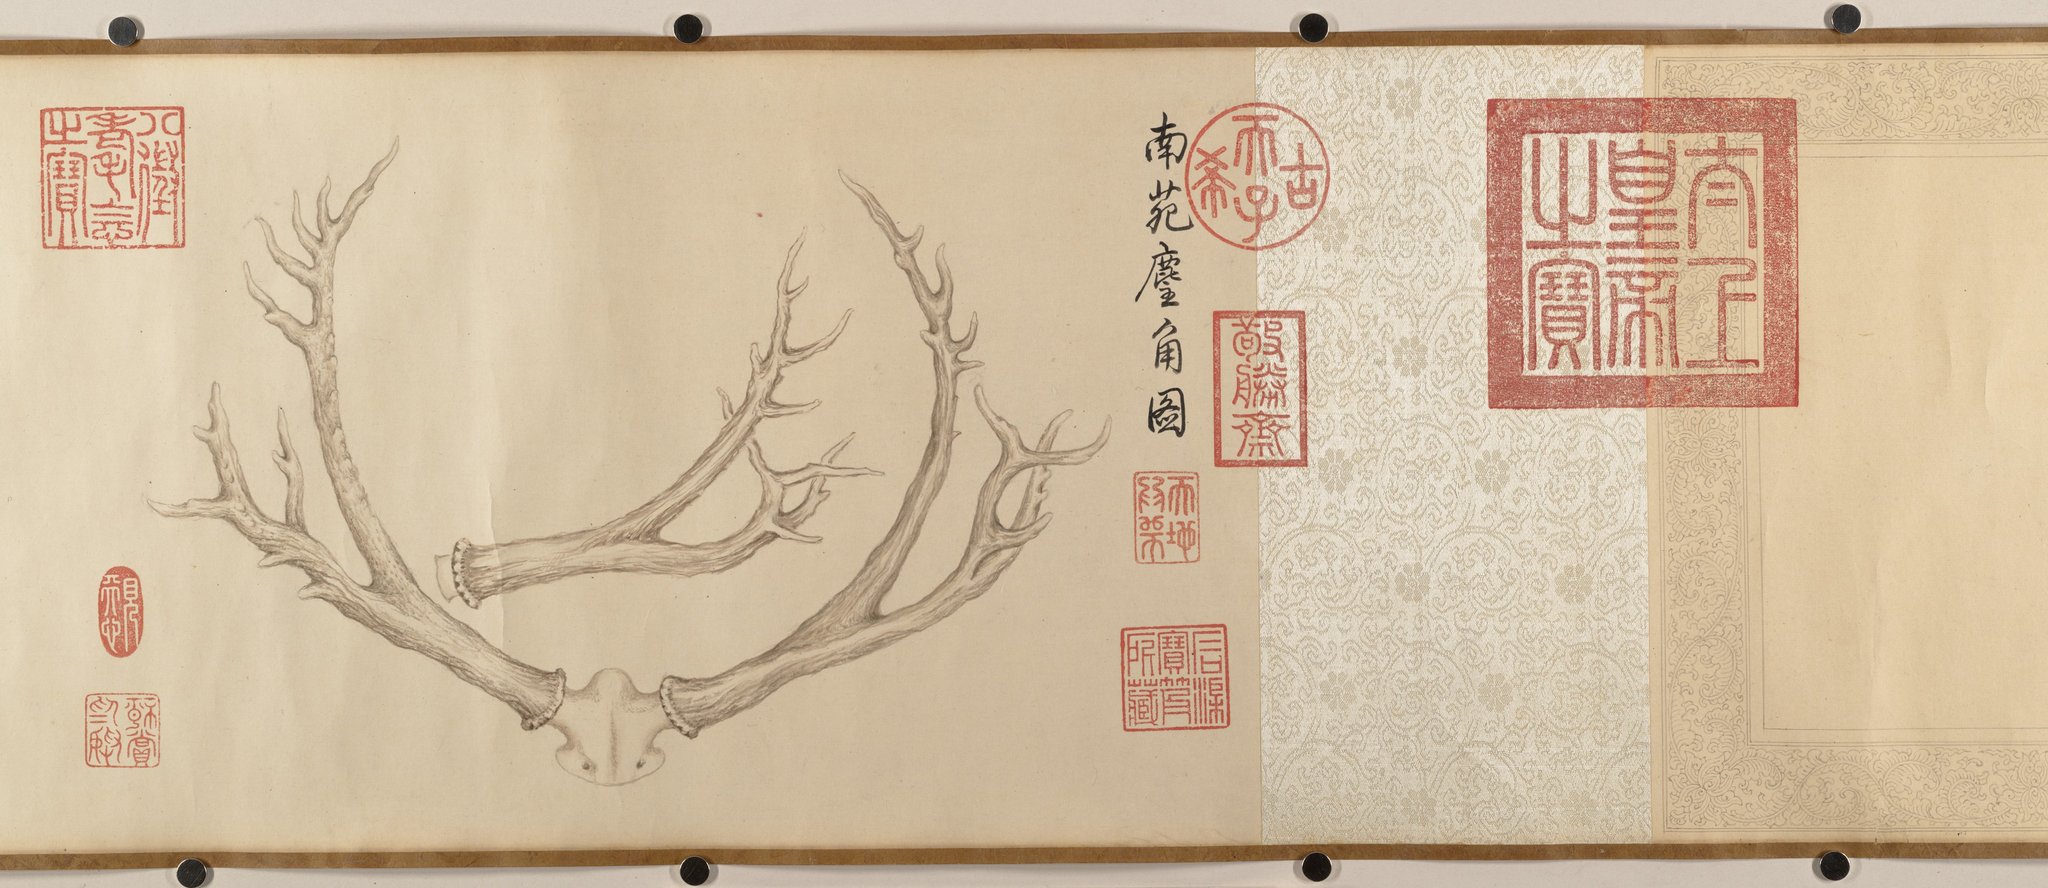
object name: handscroll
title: Two Paintings of Deer Antlers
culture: chinese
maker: qianlong emperor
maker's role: artist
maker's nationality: chinese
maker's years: 1711-1799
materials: ink, paper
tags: deer